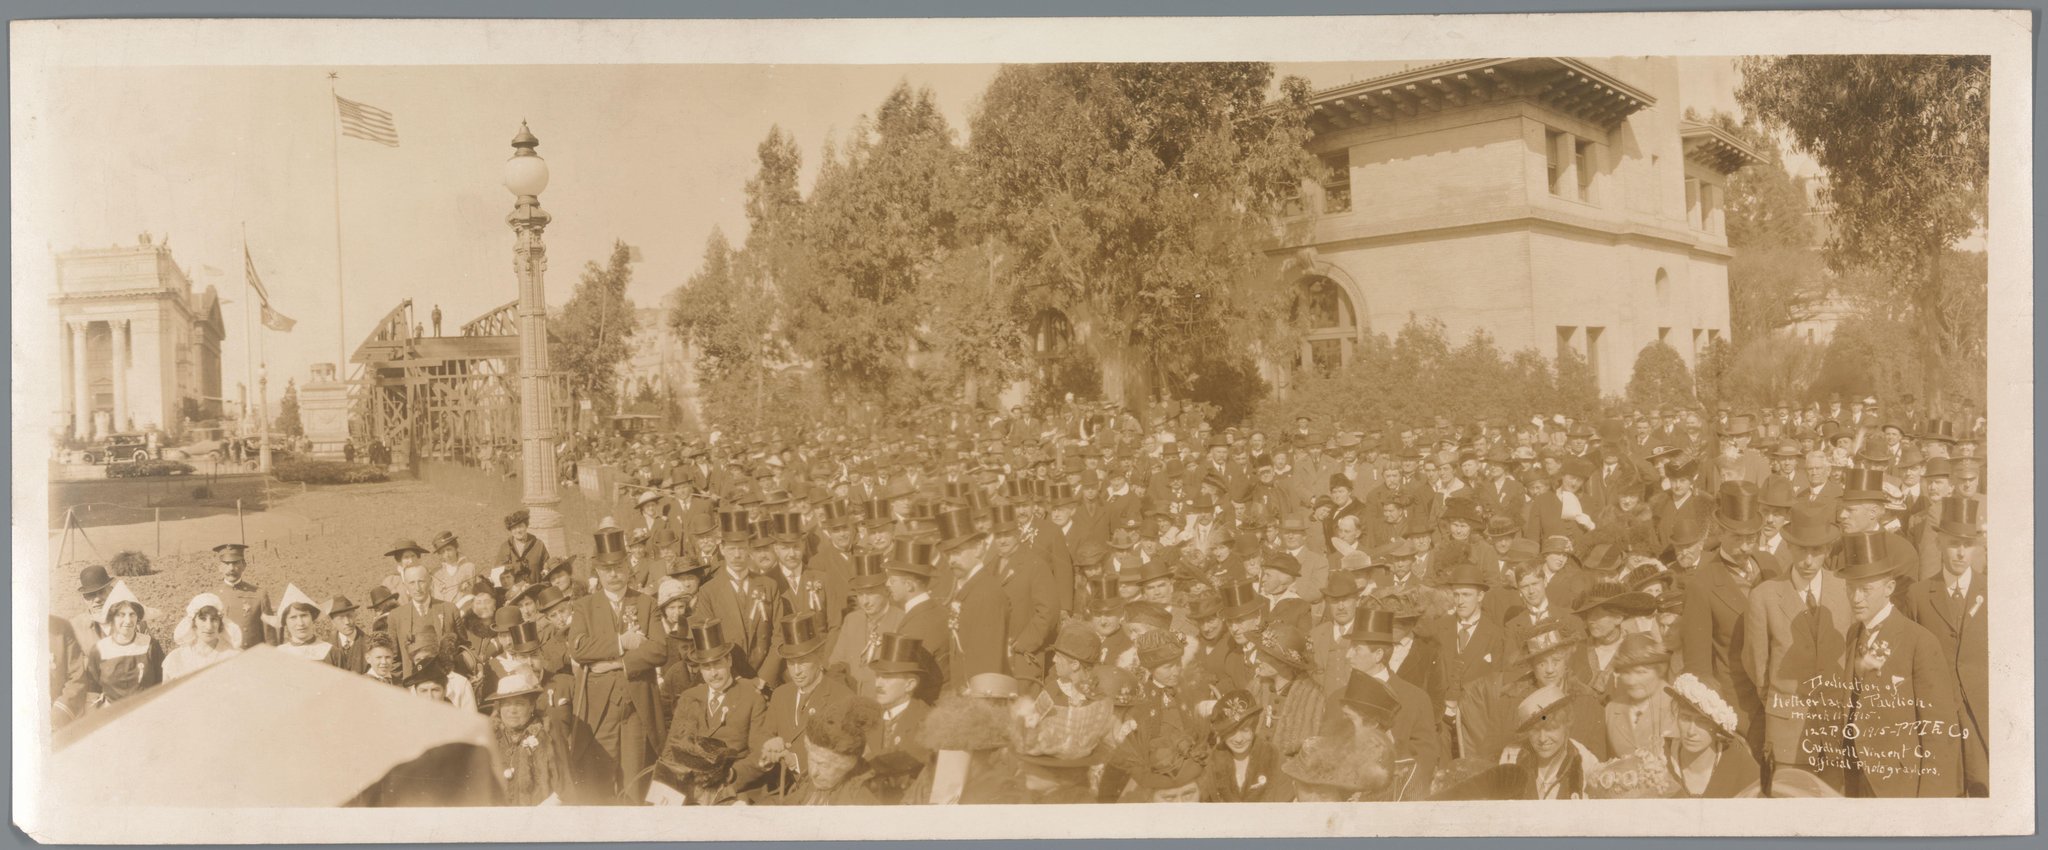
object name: photograph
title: Publiek bij Nederlands paviljoen in San Francisco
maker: Anonymous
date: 1860-1915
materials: paper, photographic support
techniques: gelatin silver print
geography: san francisco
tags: san francisco